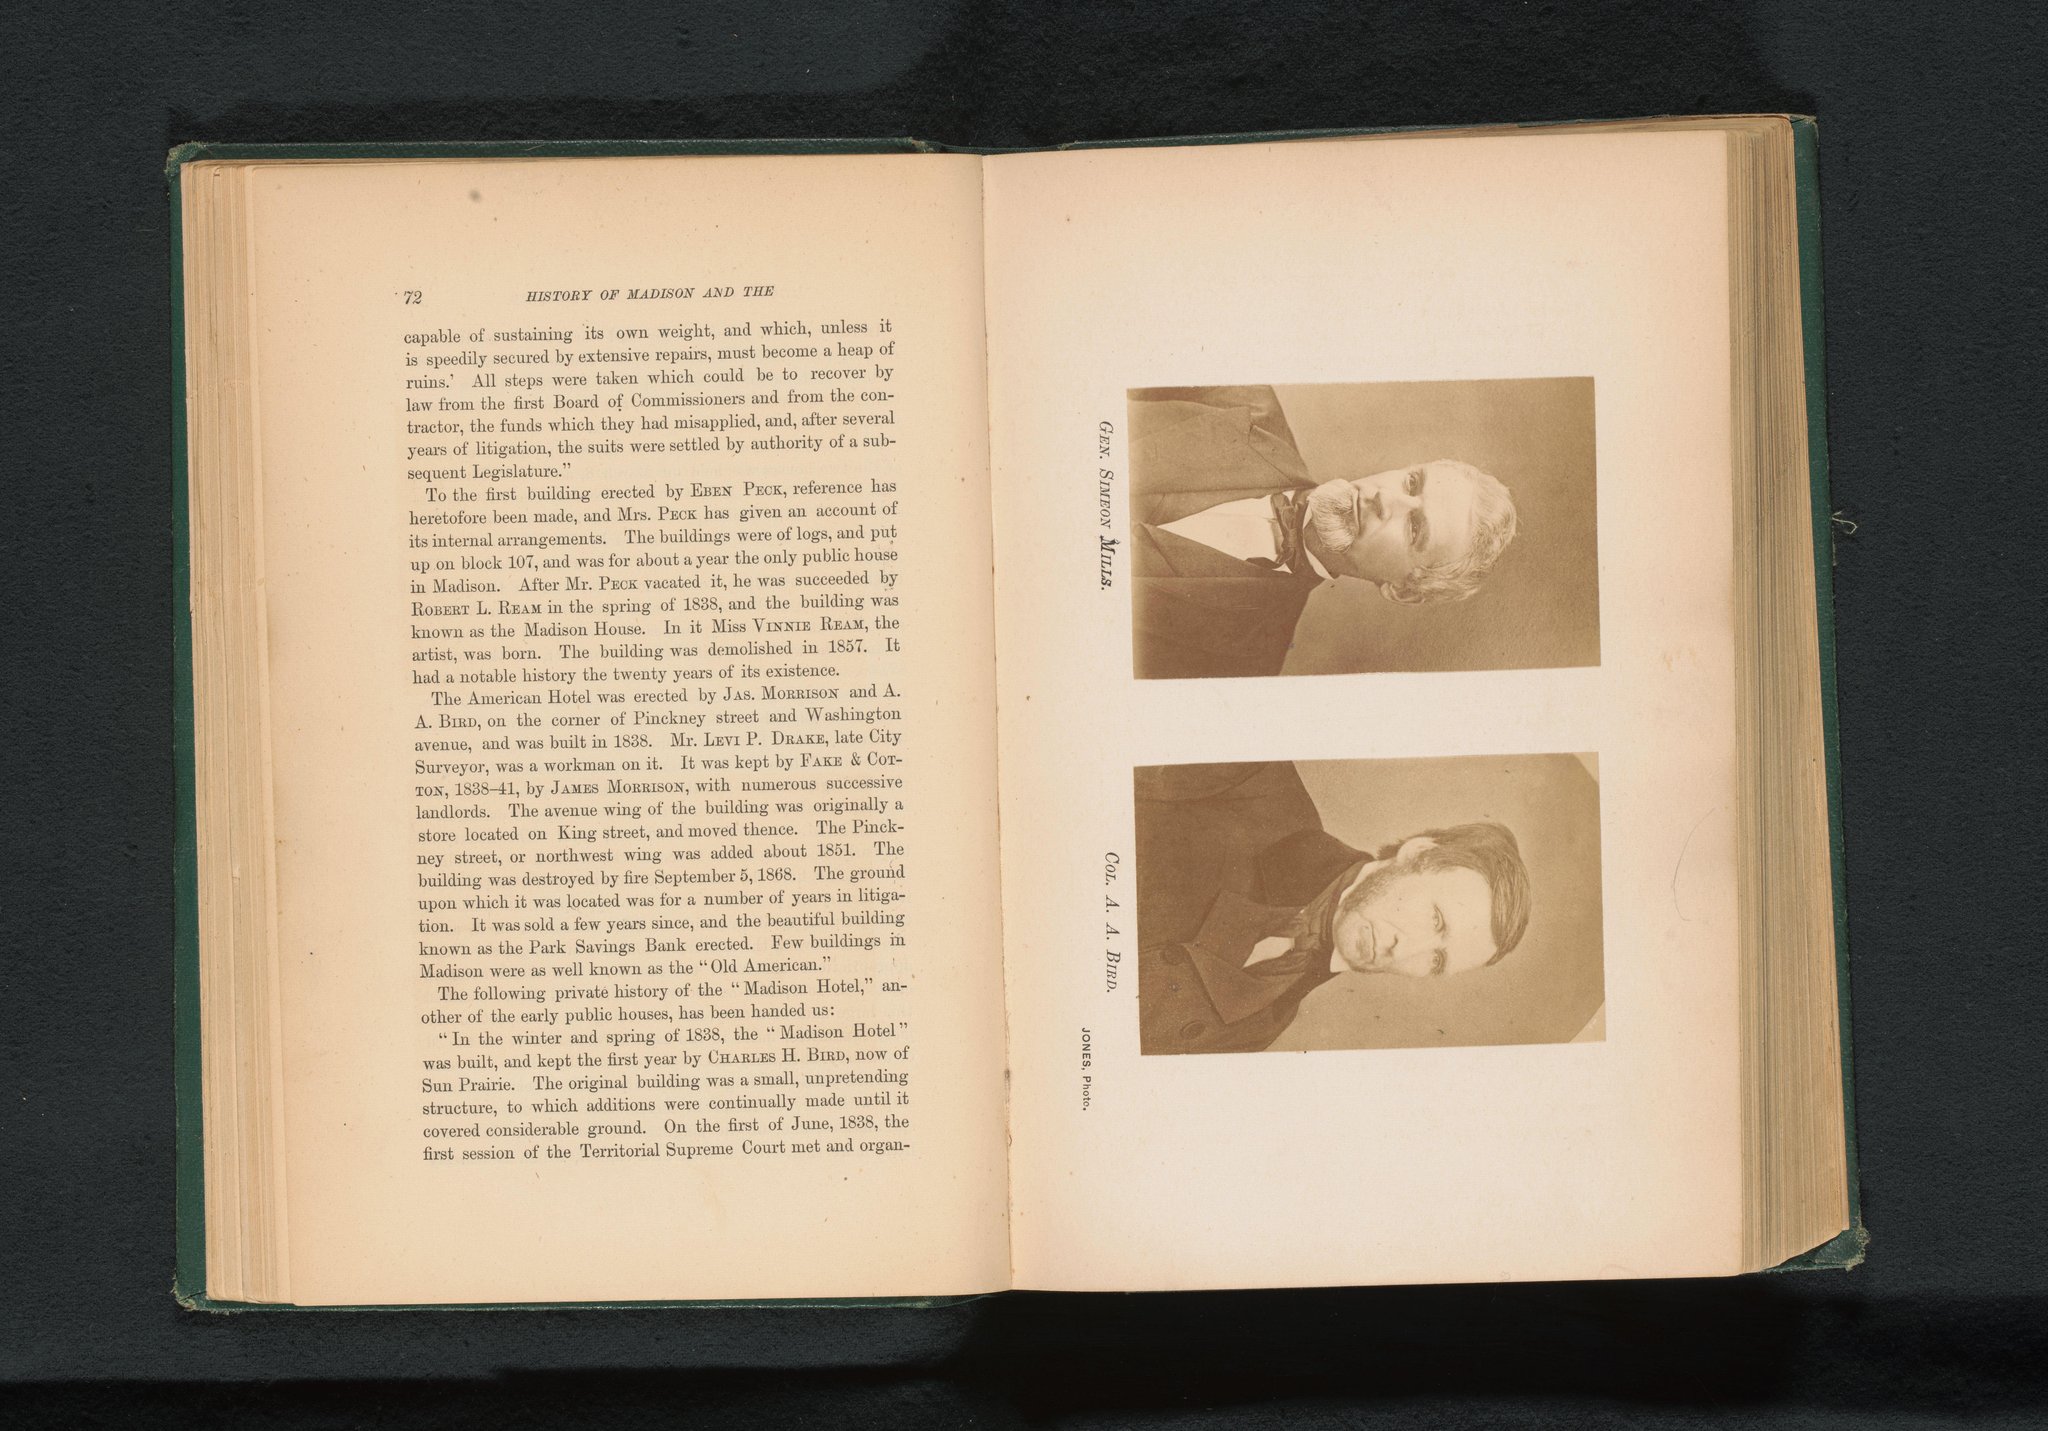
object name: photograph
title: Portretten van Simeon Mills en kolonel A.A. Bird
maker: jones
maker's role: fotograaf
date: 1864-1874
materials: photographic support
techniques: albumen print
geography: madison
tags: adult man